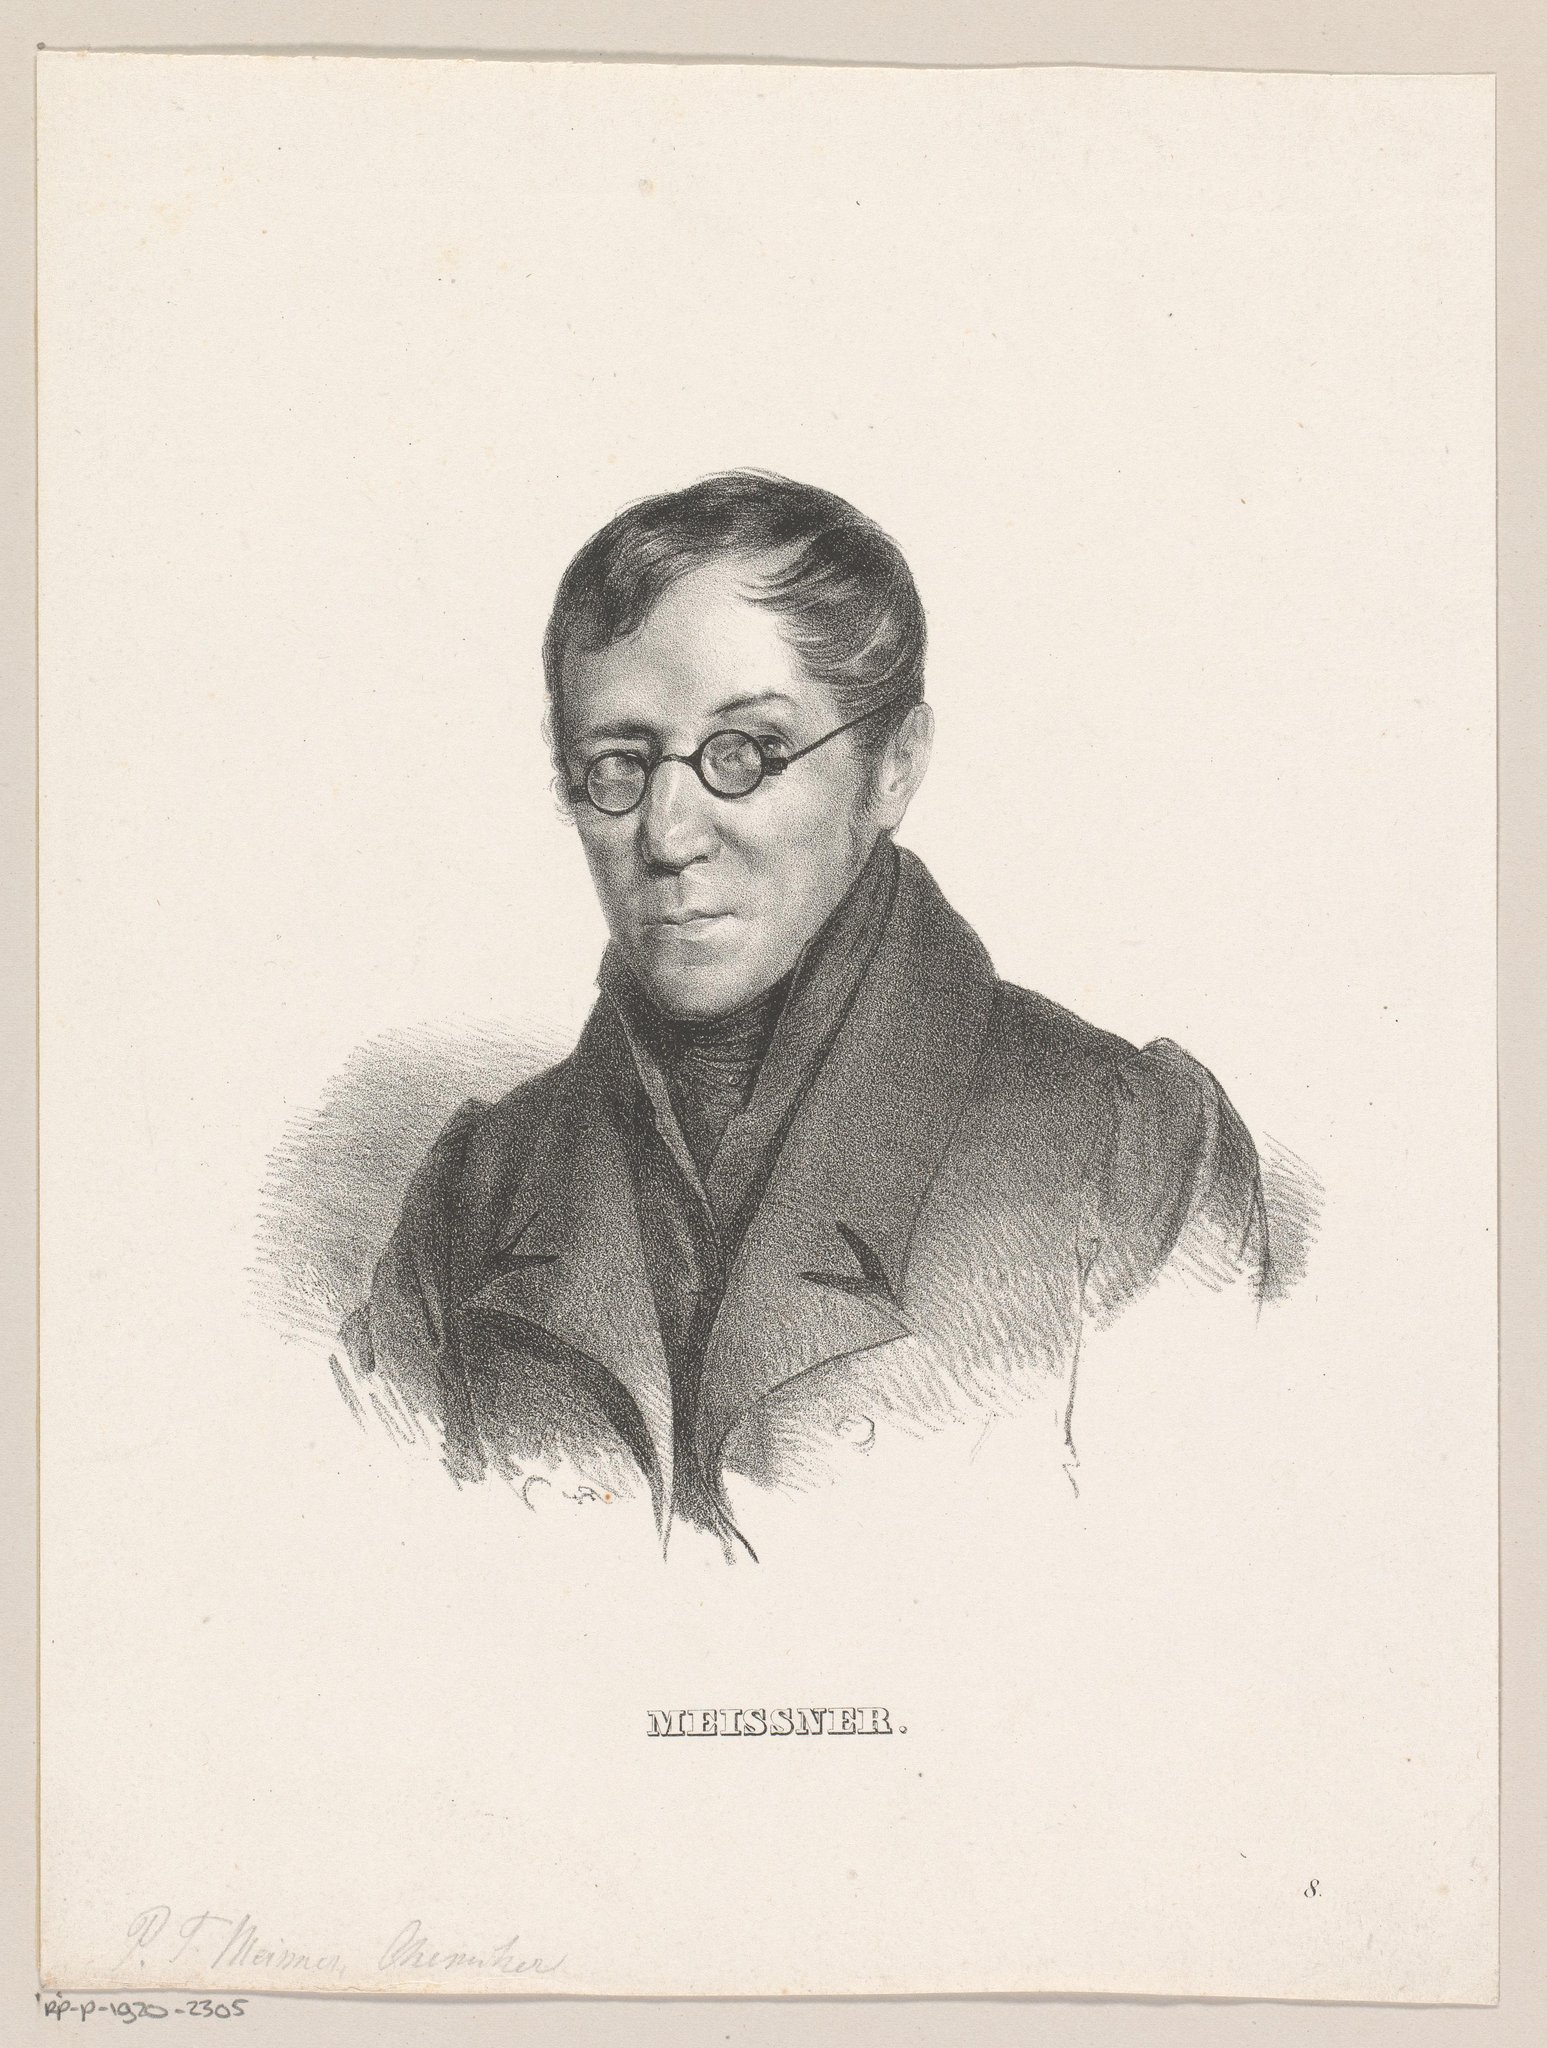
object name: print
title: Meissner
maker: Anonymous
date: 1800-1900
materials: paper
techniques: lithograph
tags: vienna, eyeglasses, spectacles, adult man, historical persons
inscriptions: collector's mark: Lugt 2228